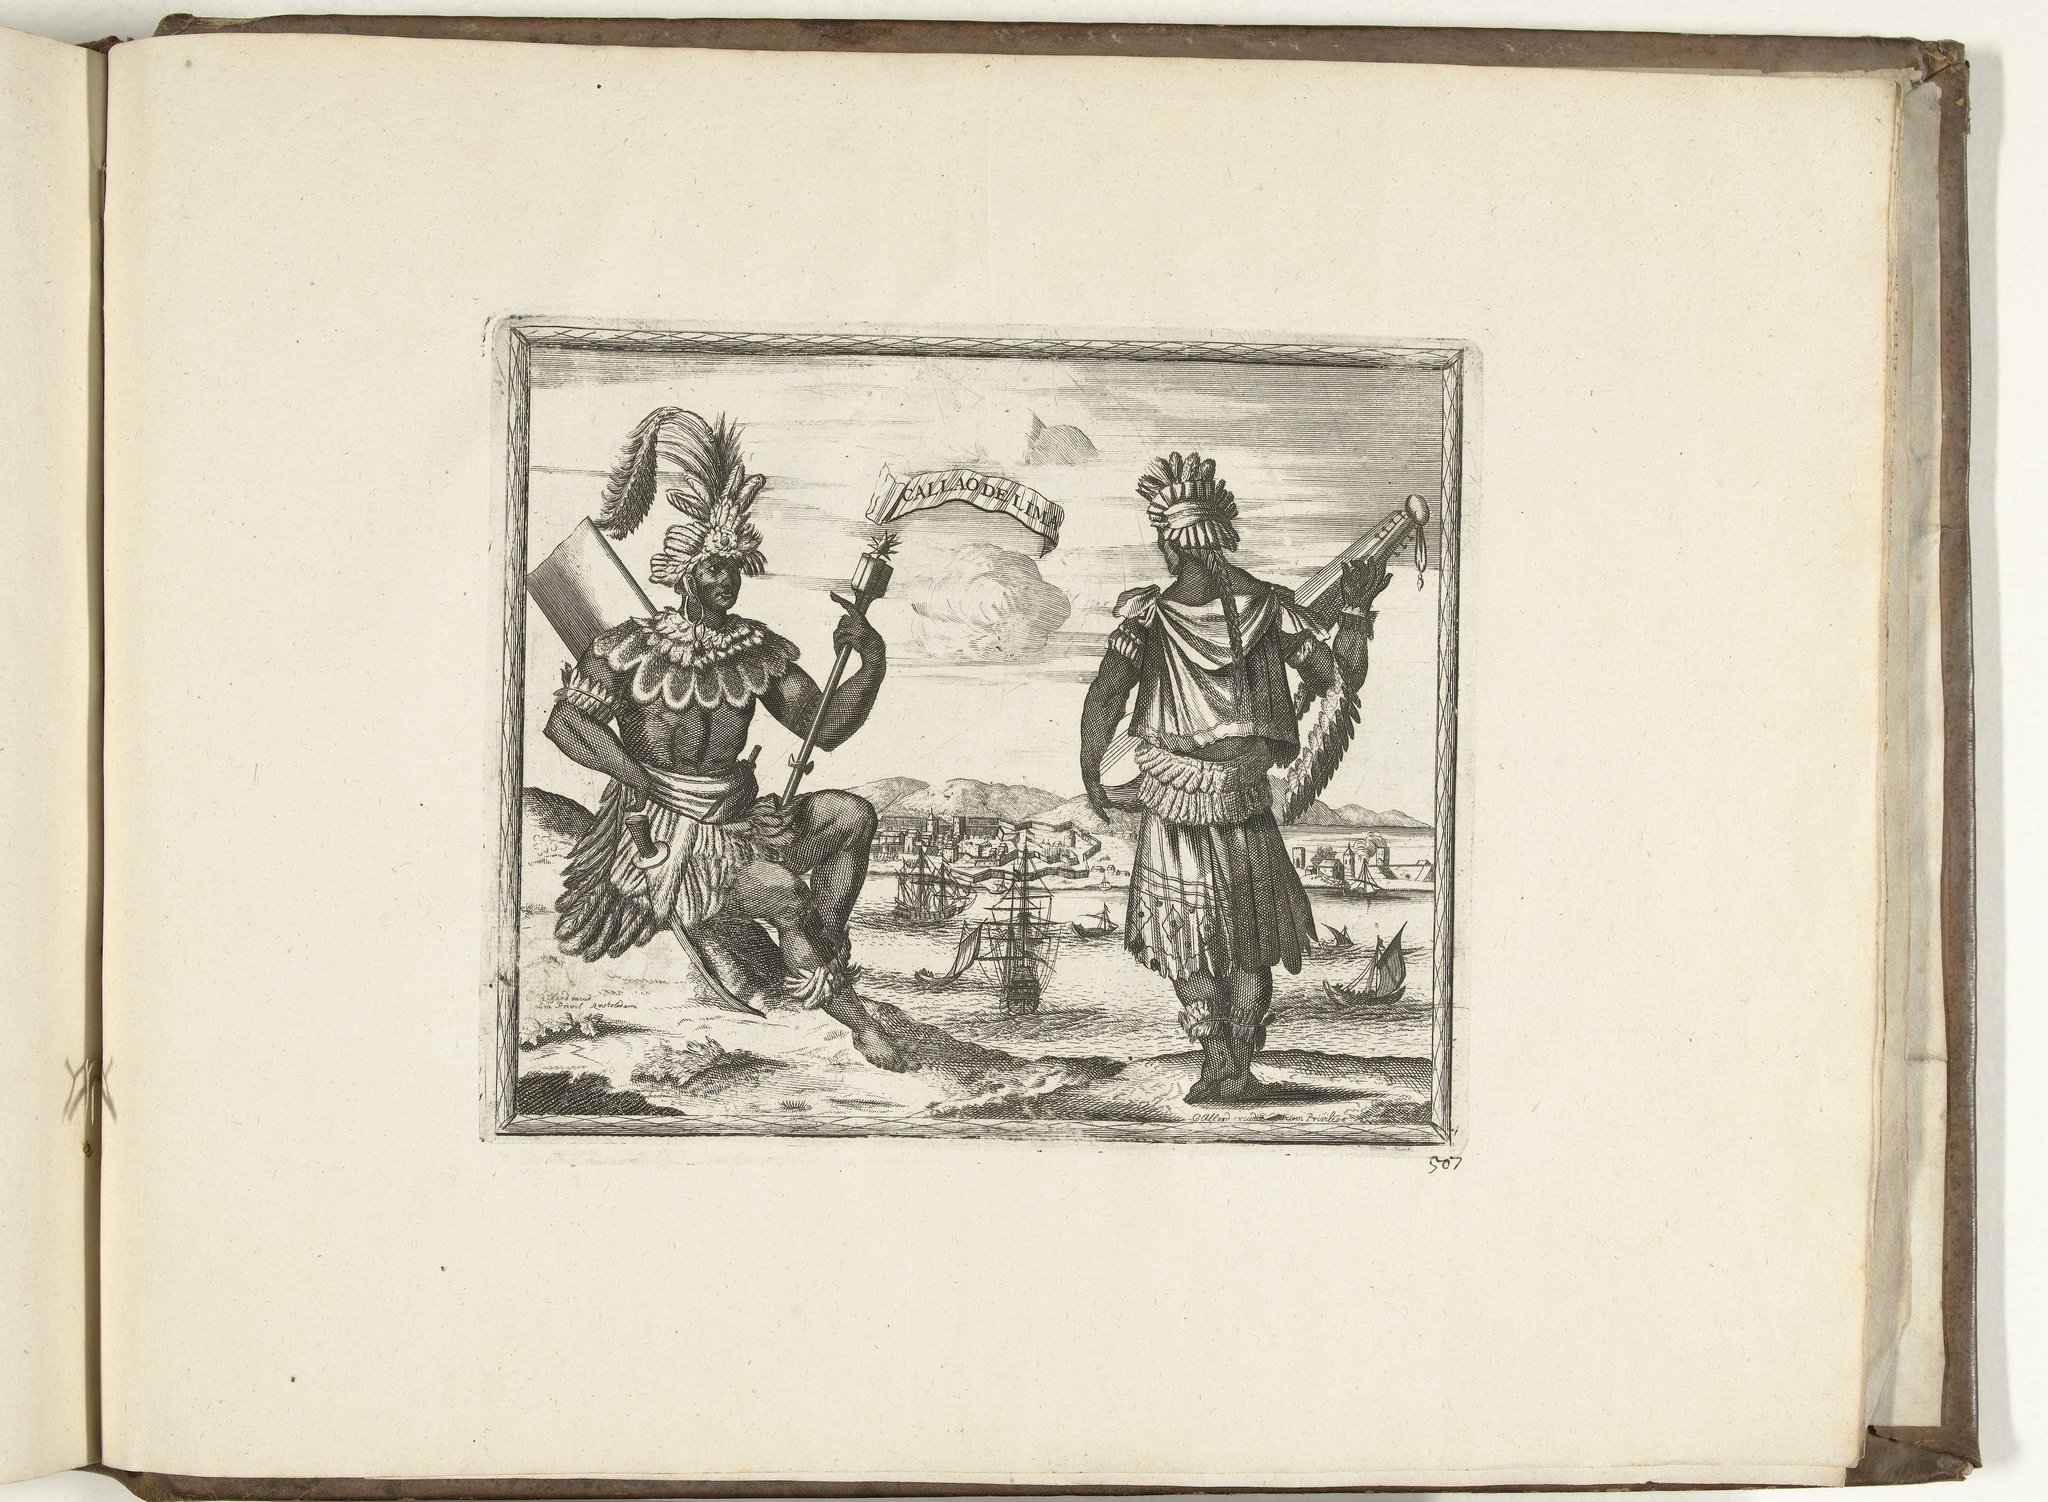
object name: print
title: Callao de Lima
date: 1726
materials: paper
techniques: engraving, etching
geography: amsterdam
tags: indigenous peoples of south america, folk costume, regional costume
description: Man en vrouw uit Callao, bij Lima in Peru, gekleed in lokaal kostuum, op de achtergrond de stad. De man met een knots, de vrouw met een snaarinstrument. Plaat nr. 507 in deel XX van het prentwerk: Les Forces de l'Europe, Asie, Afrique et Amerique ... Comme aussi les Cartes des Côtes de France et d'Espagne uit 1726, dit tweede deel met 271 met de hand genummerde platen van vermaarde sterke steden en vestingen in het kader van de Spaanse Successieoorlog 1701-1713. Voor het merendeel zijn deze platen gekopieerd naar de anonieme Franse platen van vermaarde sterke steden en vestingen: in Les forces de l'Europe en in: Le theatre de la guerre, dans les Pays-Bas, beide oorspronkelijk uitgegeven door Nicolas de Fer te Parijs (1693-1697) in het kader van de Negenjarige Oorlog.